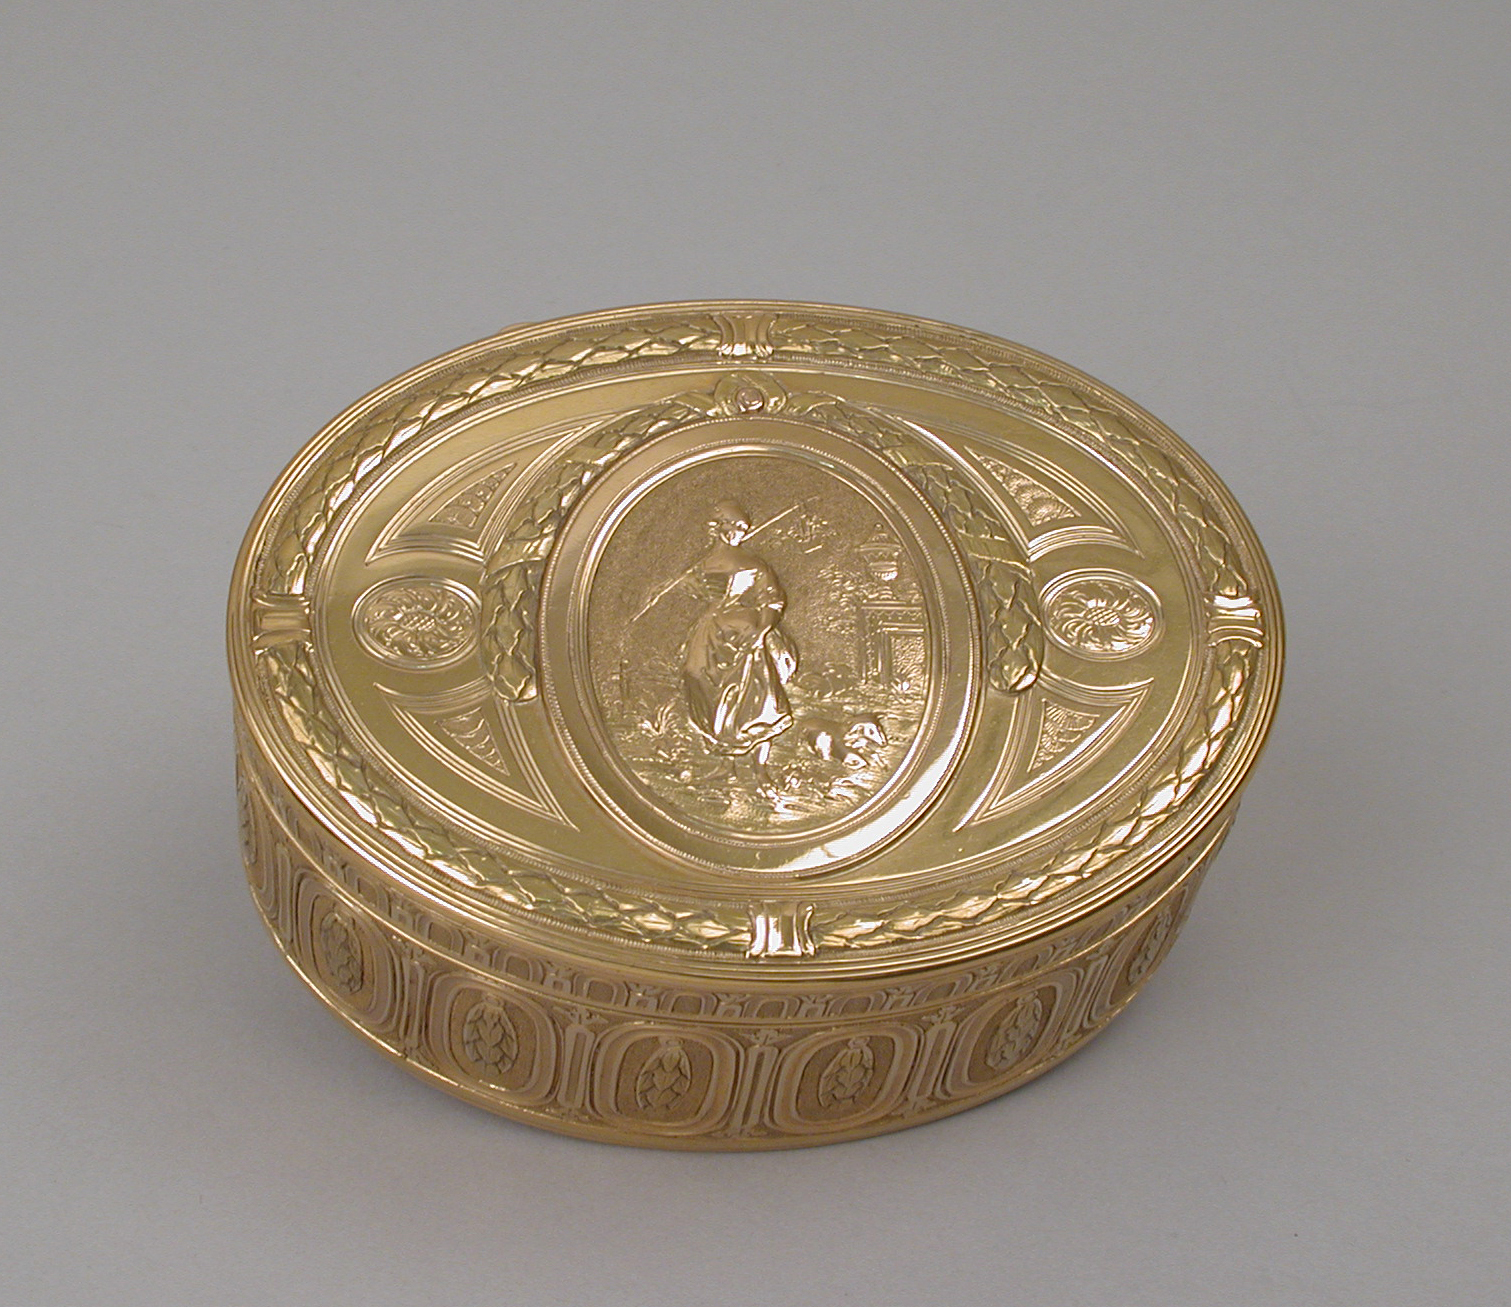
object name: snuffbox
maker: louis-philippe demay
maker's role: maker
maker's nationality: french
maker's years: 1672-1772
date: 1764-1765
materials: gold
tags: human figures,animals,flowers